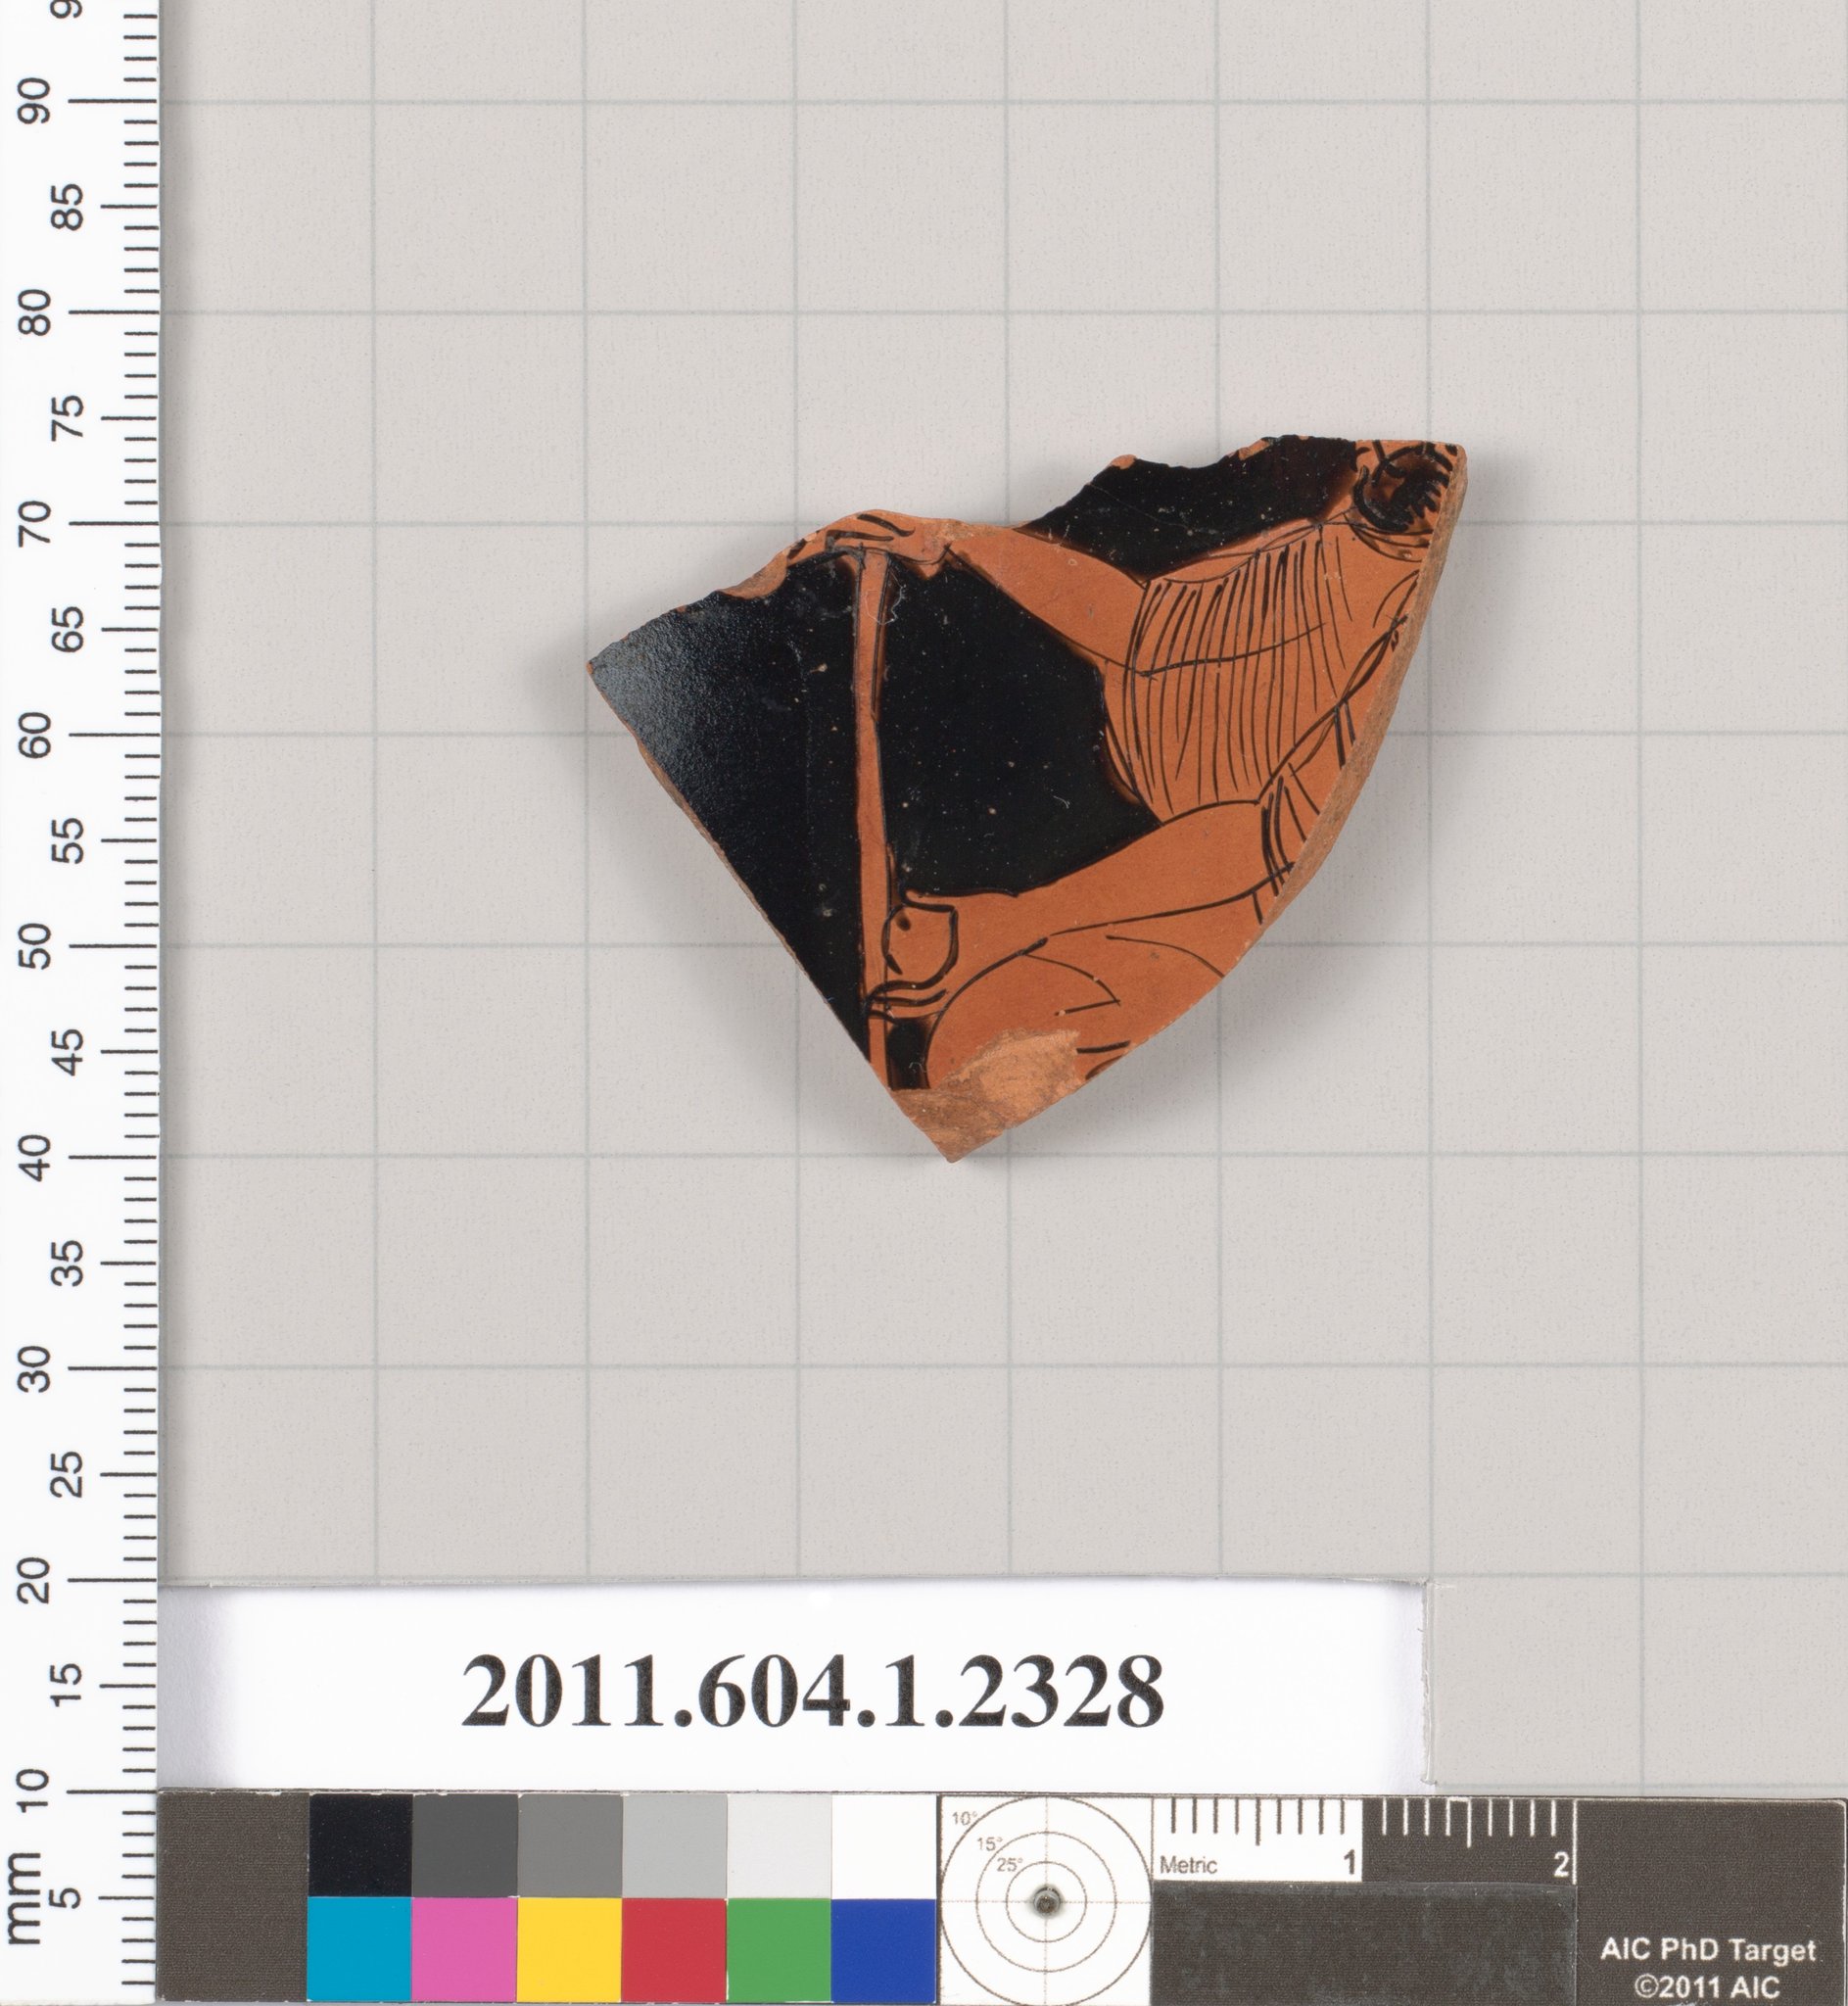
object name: kylix fragment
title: Terracotta fragment of a kylix (drinking cup)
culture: greek, attic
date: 475-451 BCE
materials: terracotta